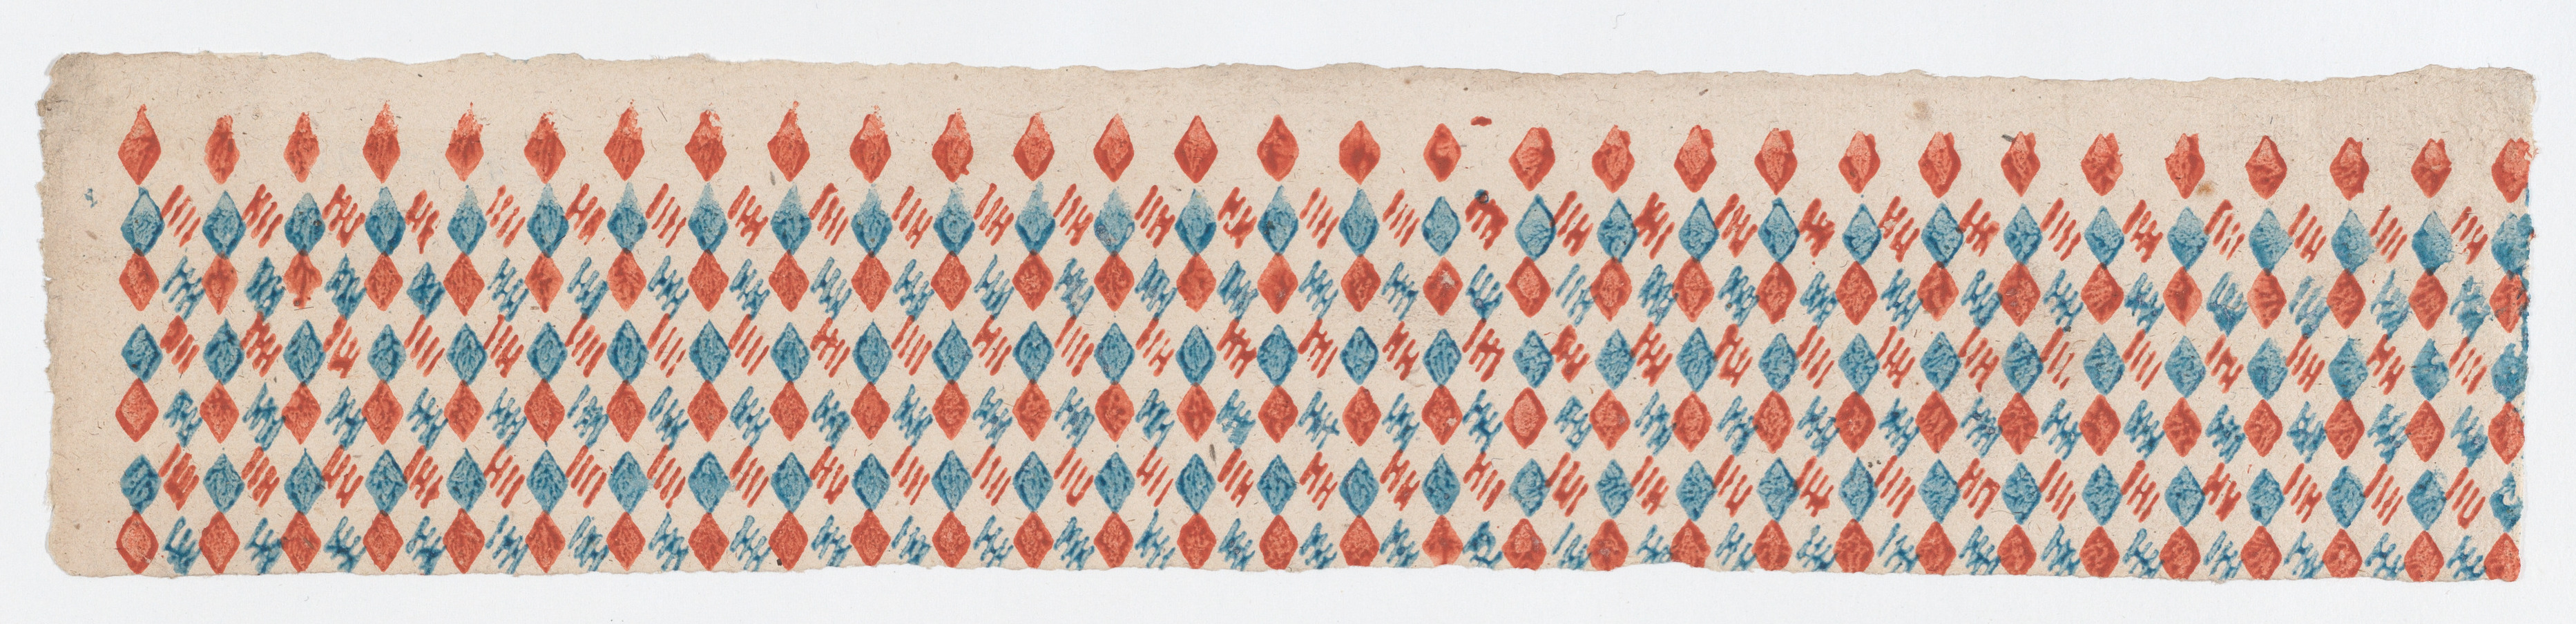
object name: print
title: Sheet with overall blue and red diamond pattern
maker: Anonymous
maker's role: artist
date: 1801-1900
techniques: relief print